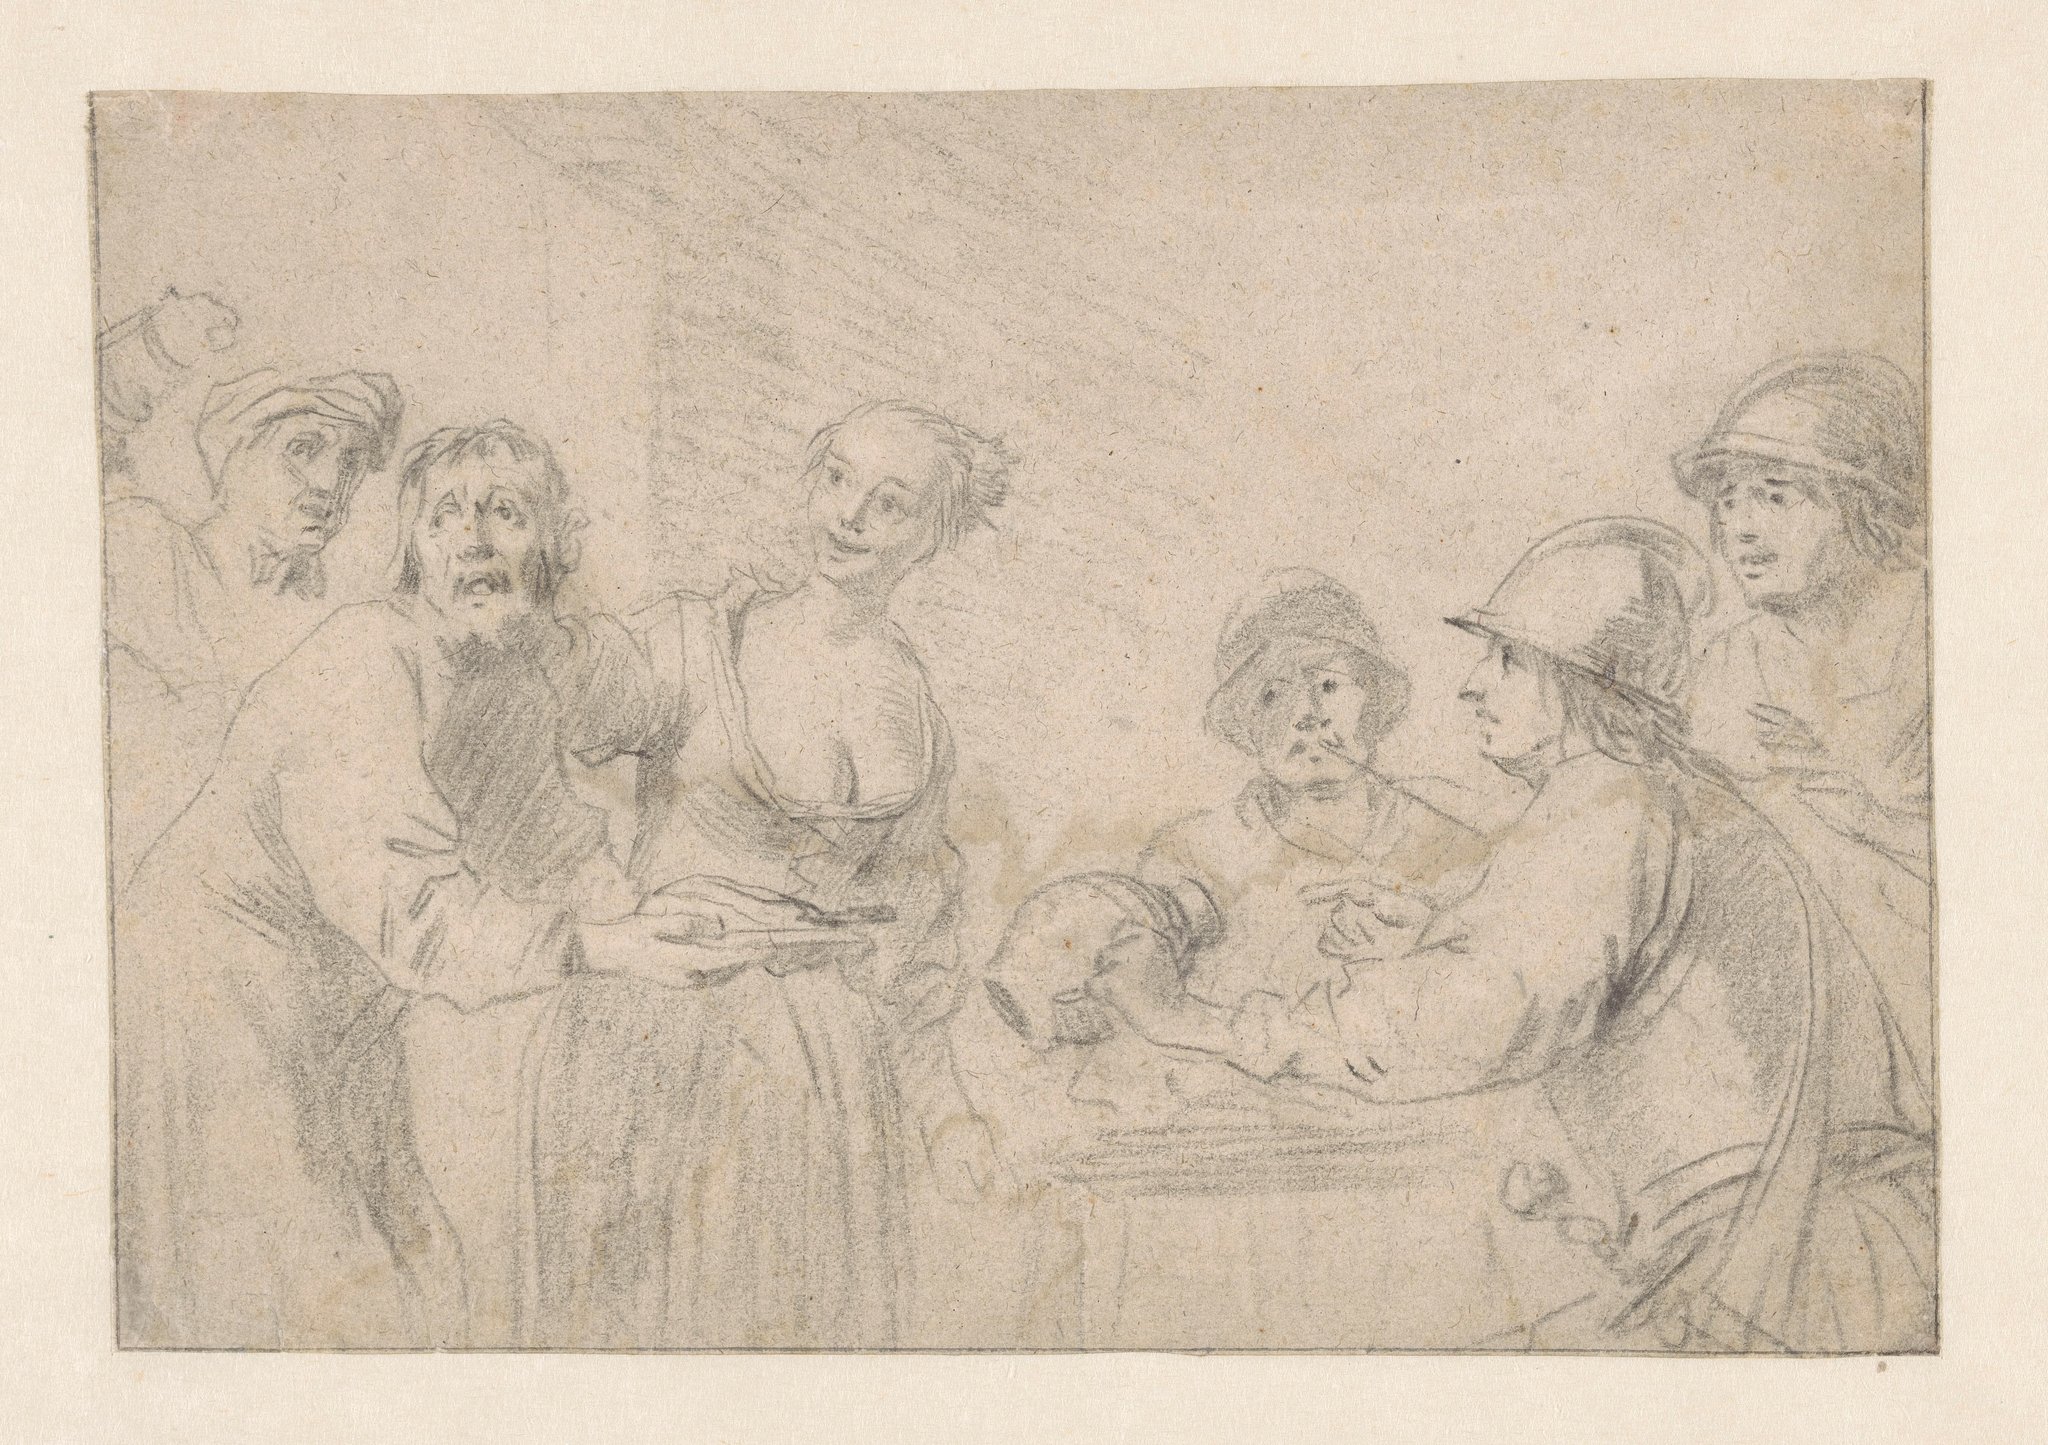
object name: drawing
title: Soldaten die zich laten bedienen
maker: pieter fransz de grebber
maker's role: painter, print maker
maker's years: 1600-1653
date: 1605-1653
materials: chalk, paper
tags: 43b31(+29)